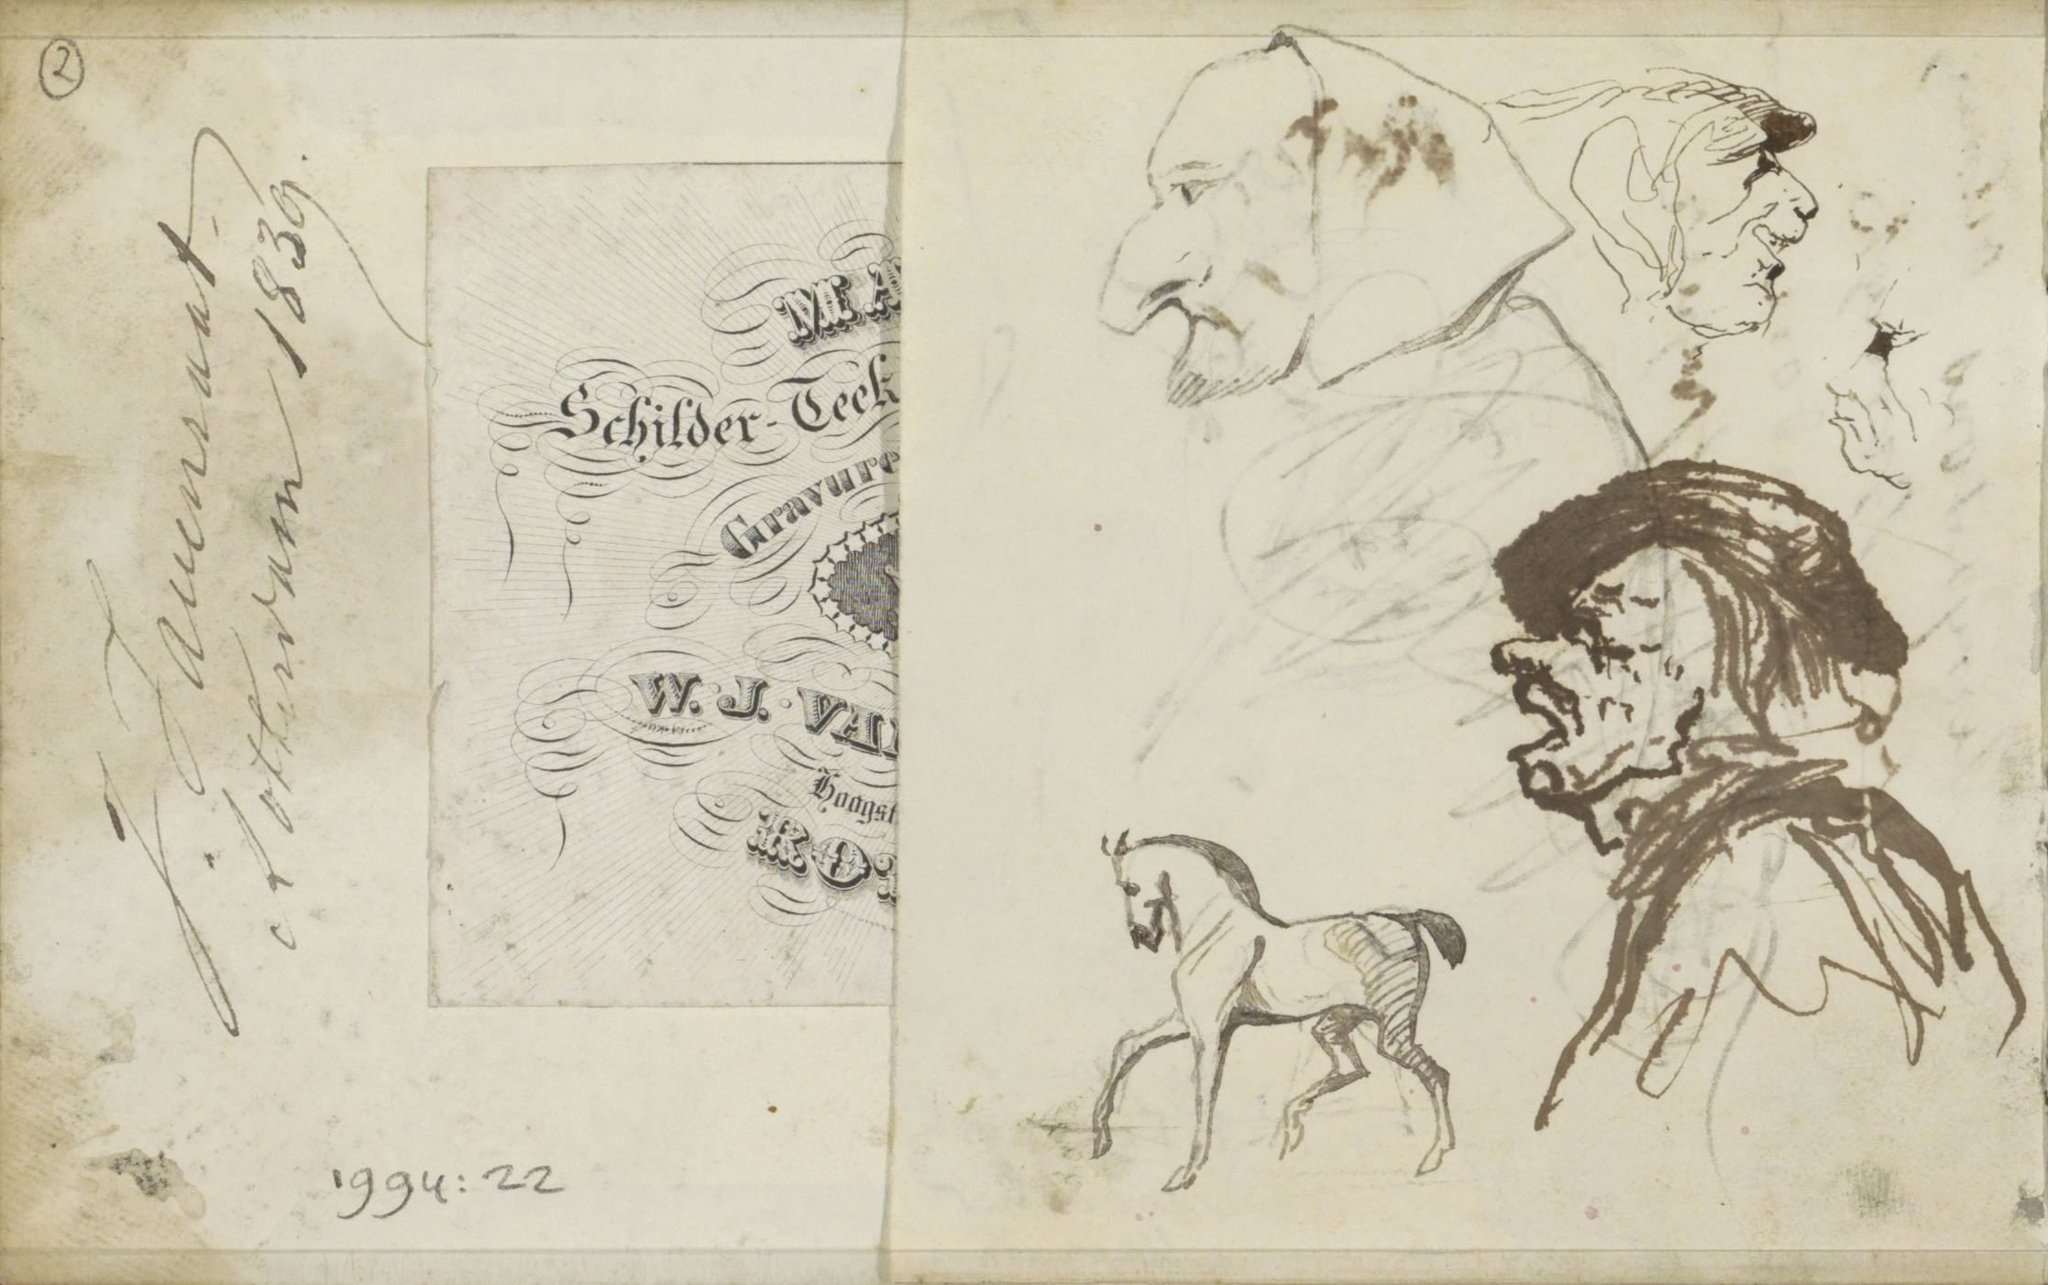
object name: sketchbook leaf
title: Studieblad, onder andere met een monnik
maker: johannes tavenraat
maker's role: draughtsman, painter, print maker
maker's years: 1809-1881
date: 1839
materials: paper, pencil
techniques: pen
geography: ginneken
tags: head (human), adult man, monk(s), friar(s), horse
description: Tevens studies van een paard en oude man. Blad 1 verso uit een schetsboek met 37 bladen.